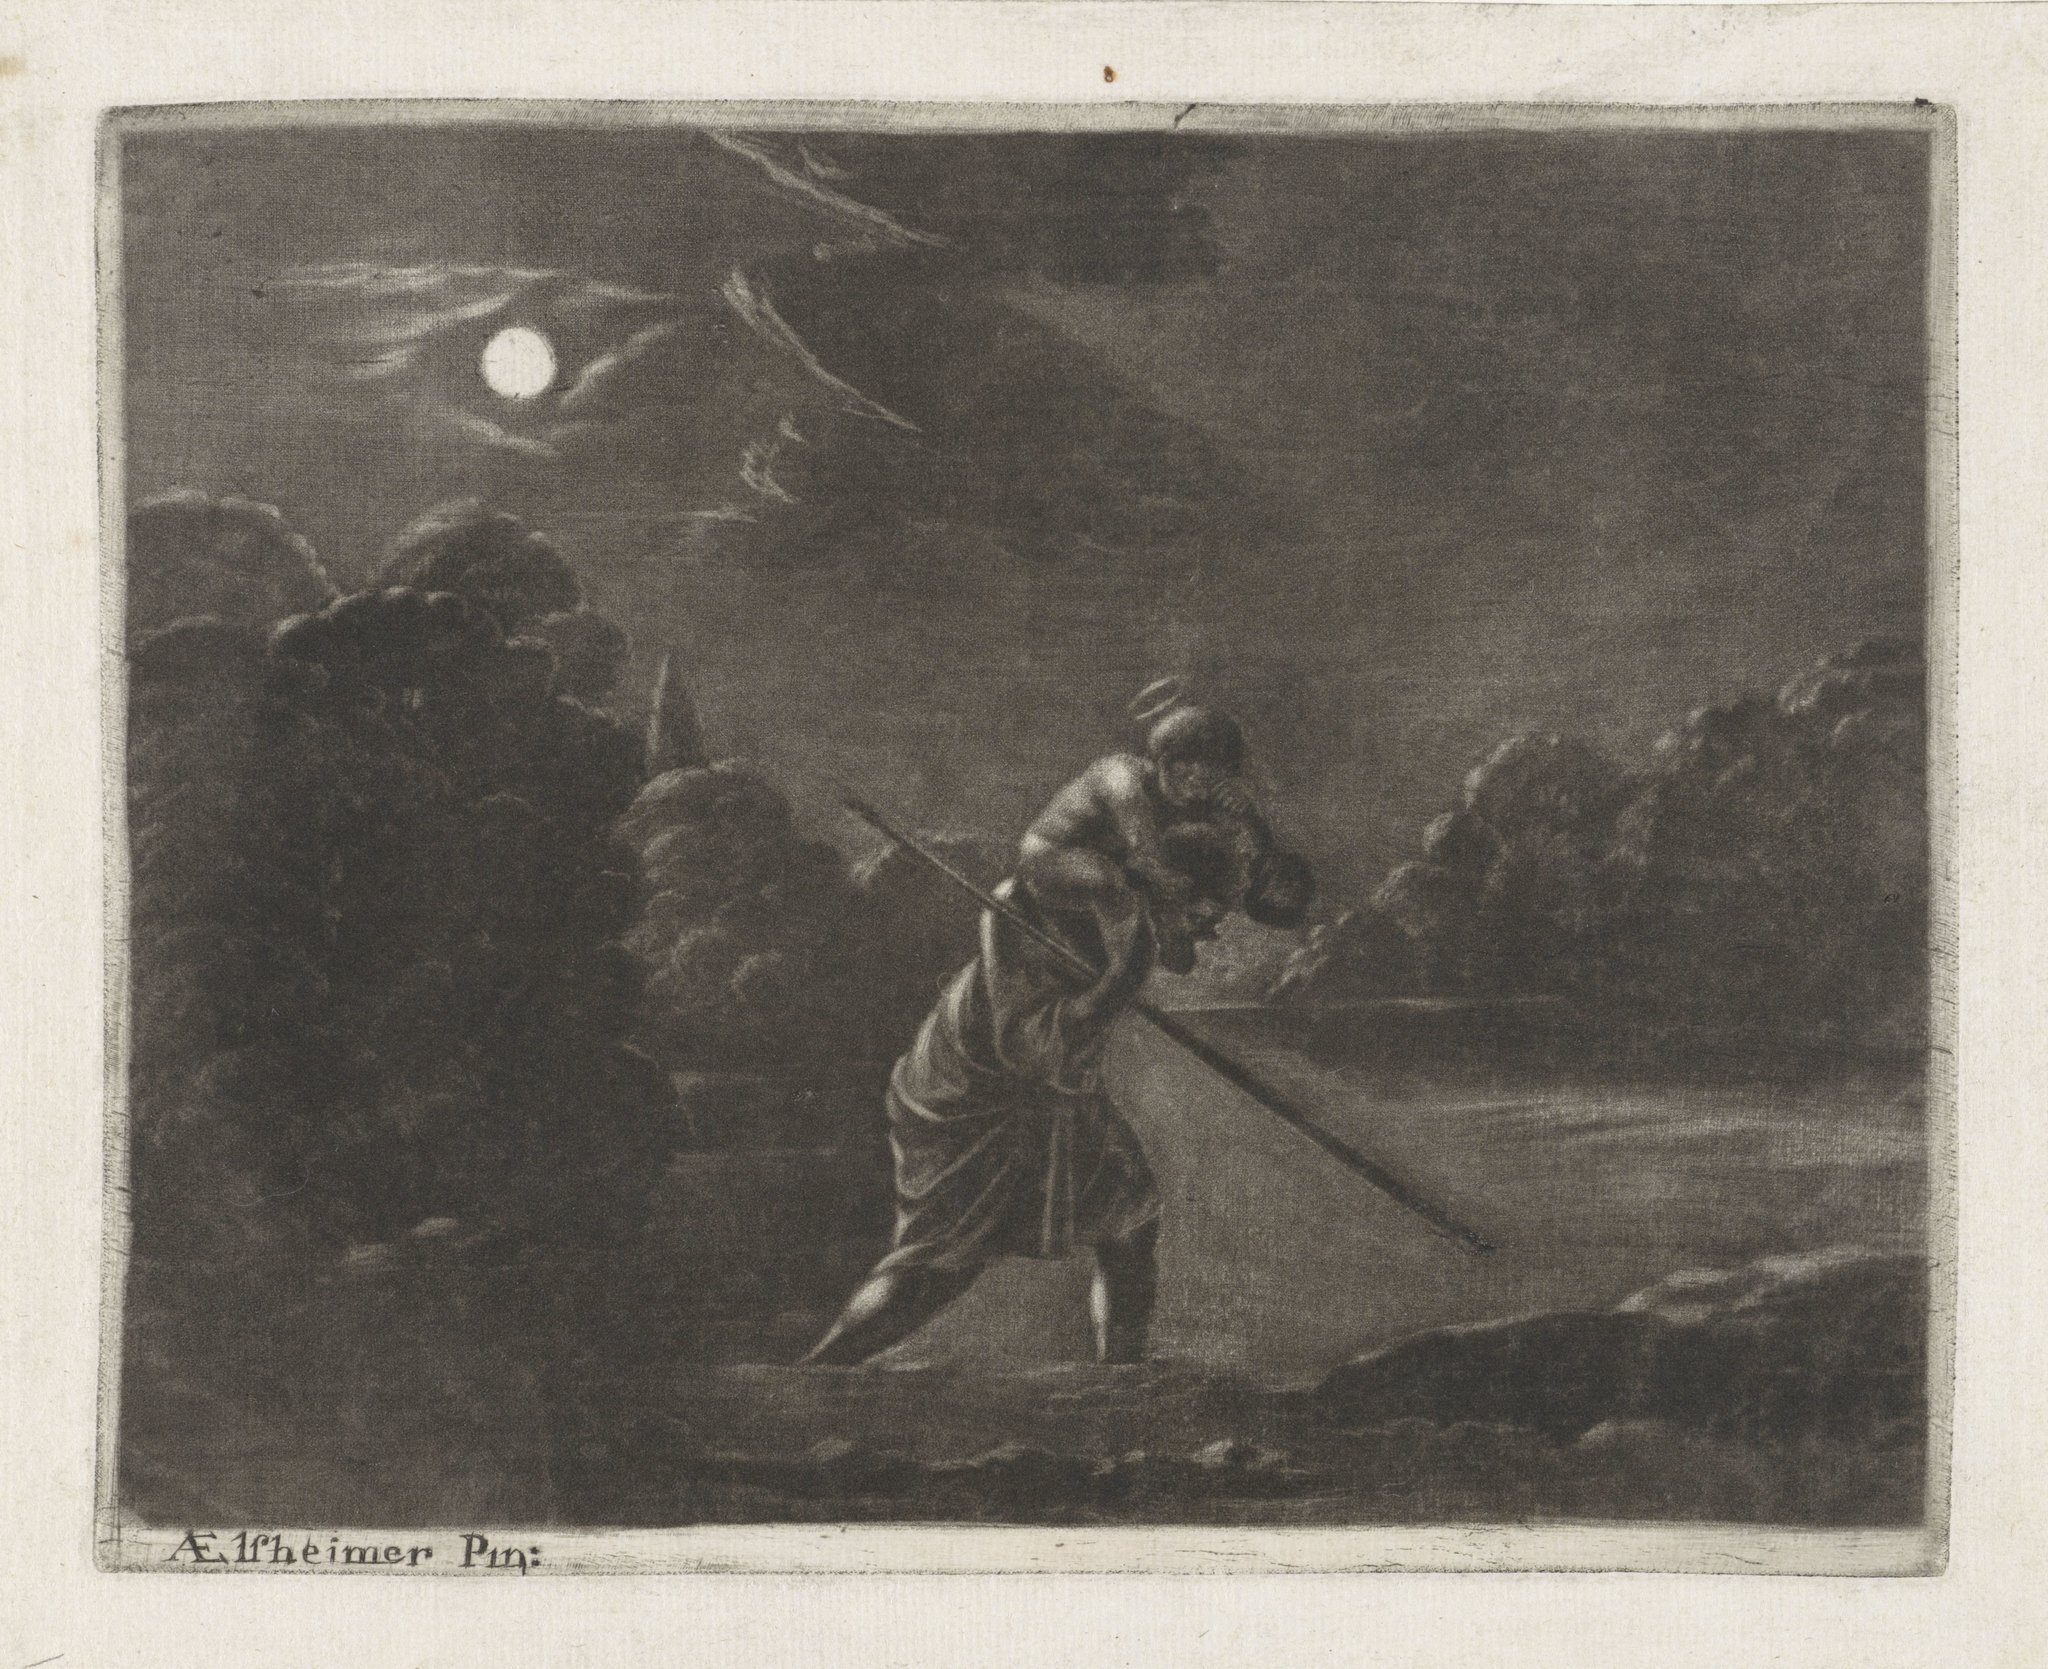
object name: print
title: H. Christoffel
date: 1658-1727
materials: paper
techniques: mezzotint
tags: moonlight, the giant and martyr christophorus; possible attributes: palm-tree (with bunches of dates, or withered), infant christ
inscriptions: collector's mark: Lugt 2228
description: De H. Christoffel waadt bij het licht van de maan door een rivier met het Christuskind op zijn schouders.